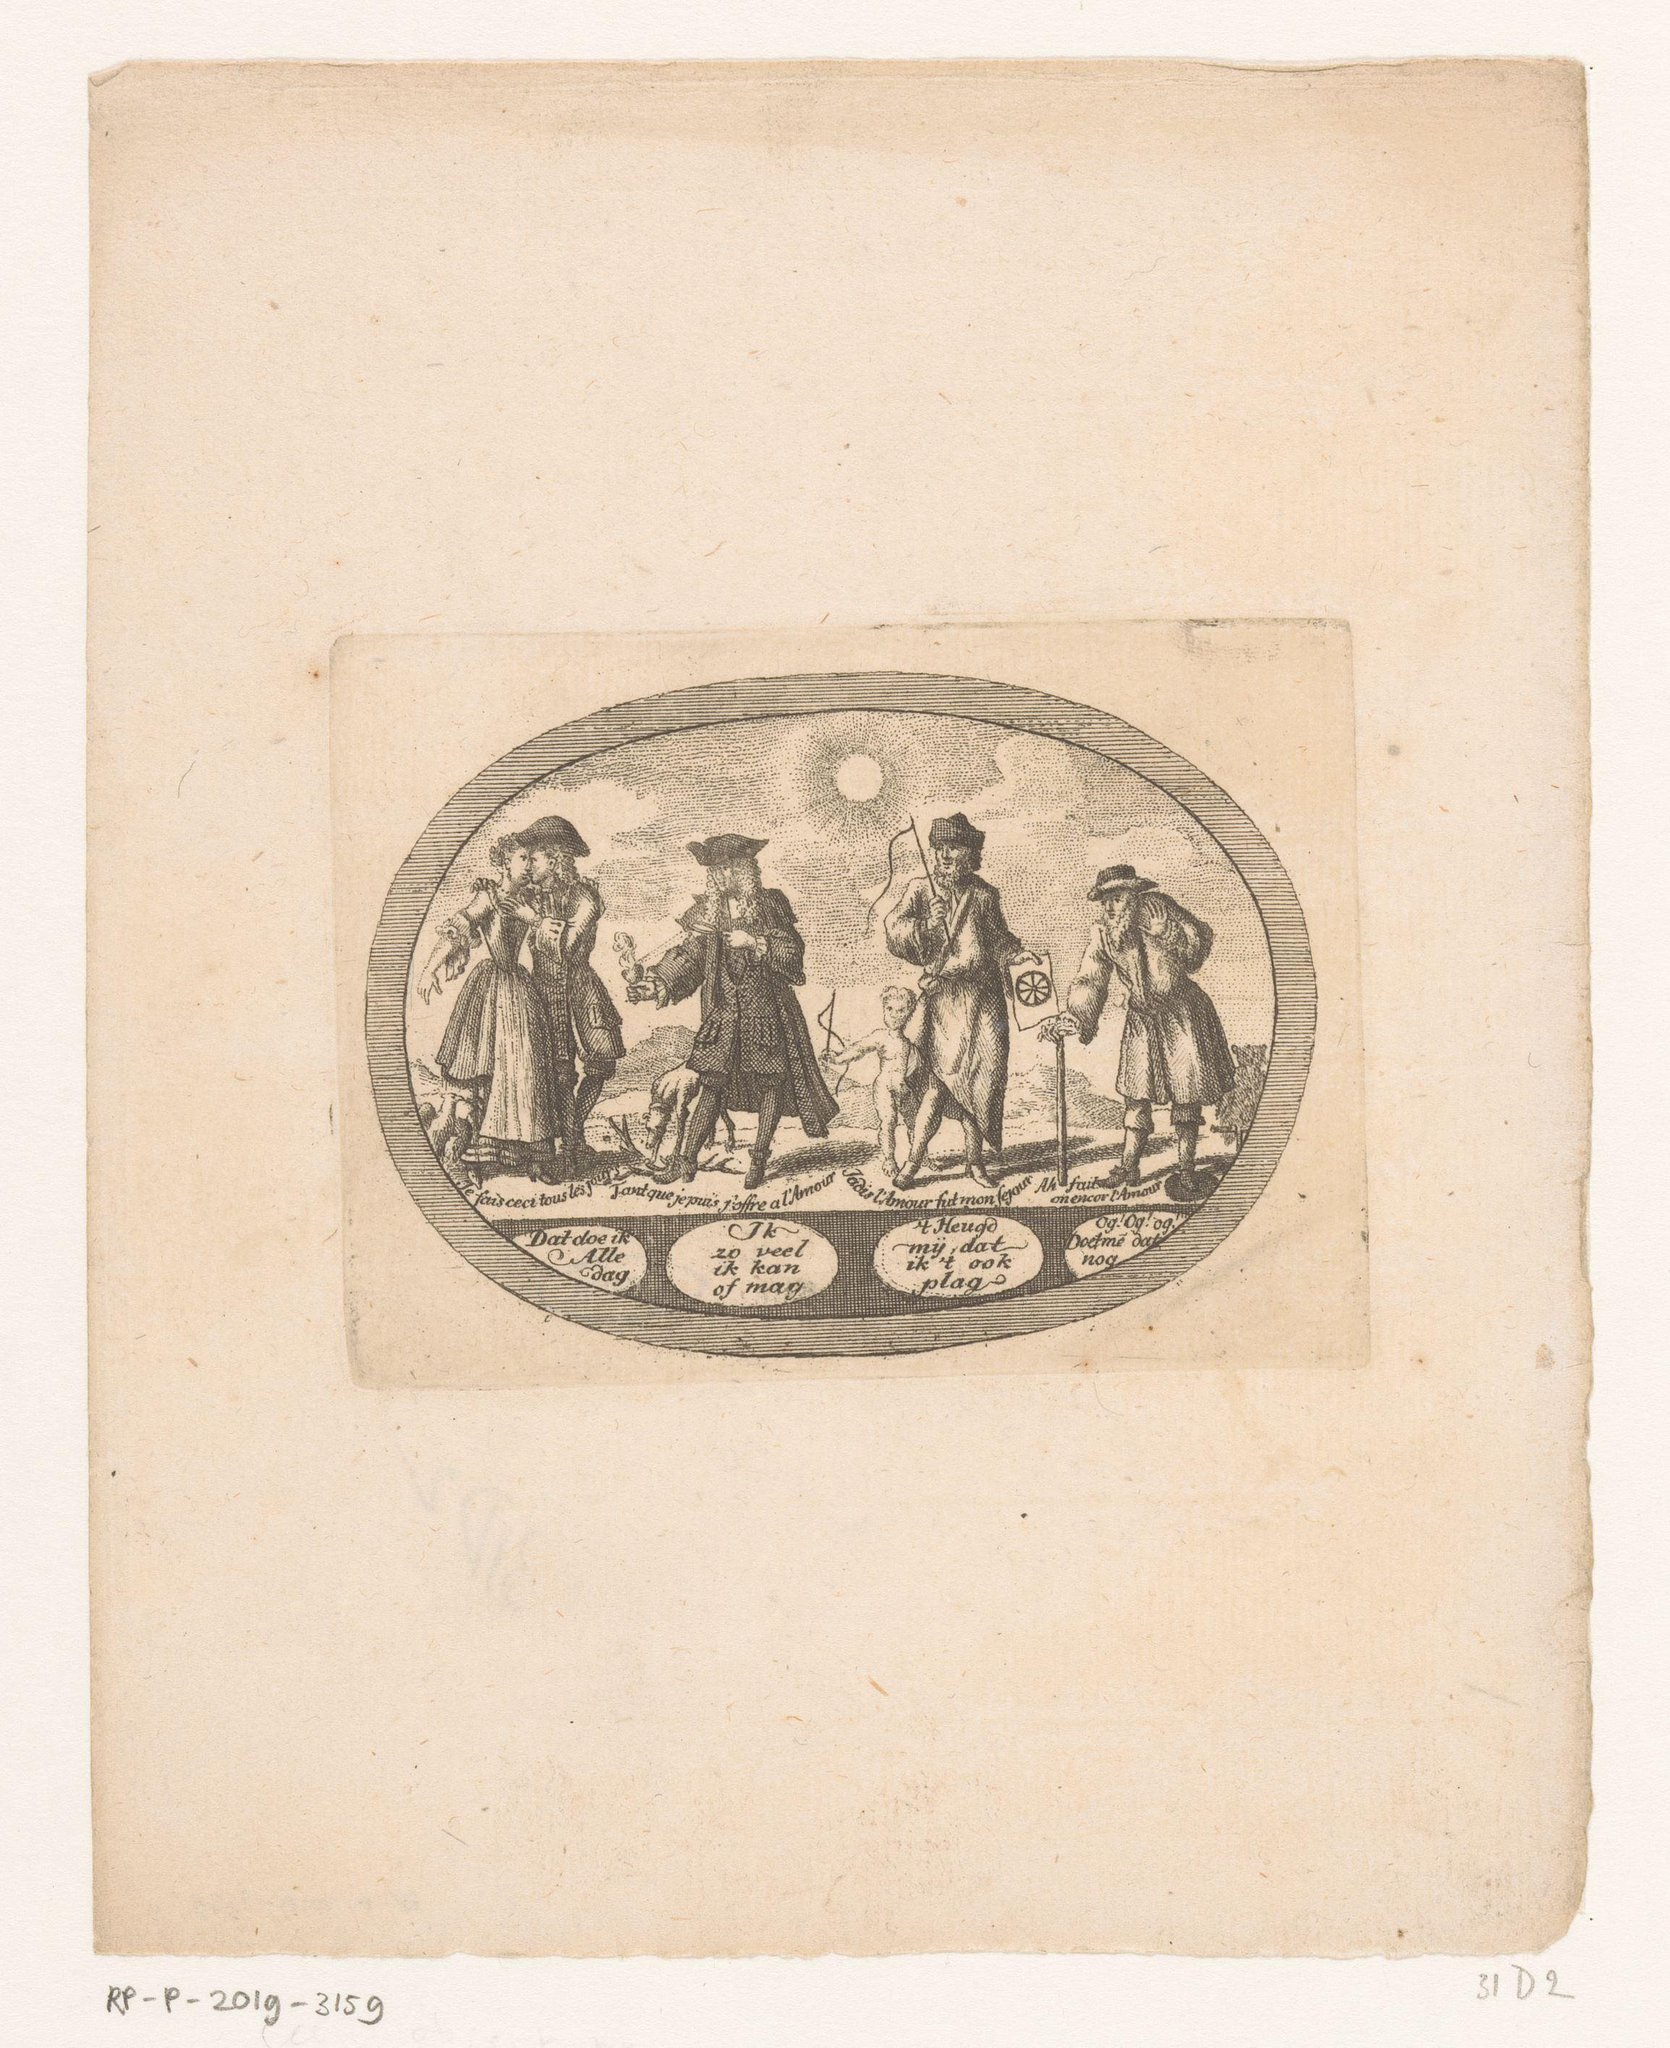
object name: print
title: Allegorie op de leeftijden en de liefde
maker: Anonymous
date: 1700-1799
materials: paper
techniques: etching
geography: netherlands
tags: (personifications and symbolic representations of) love; 'amore (secondo seneca)' (ripa), human life divided into stages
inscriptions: watermark, collector's mark: Lugt 2228